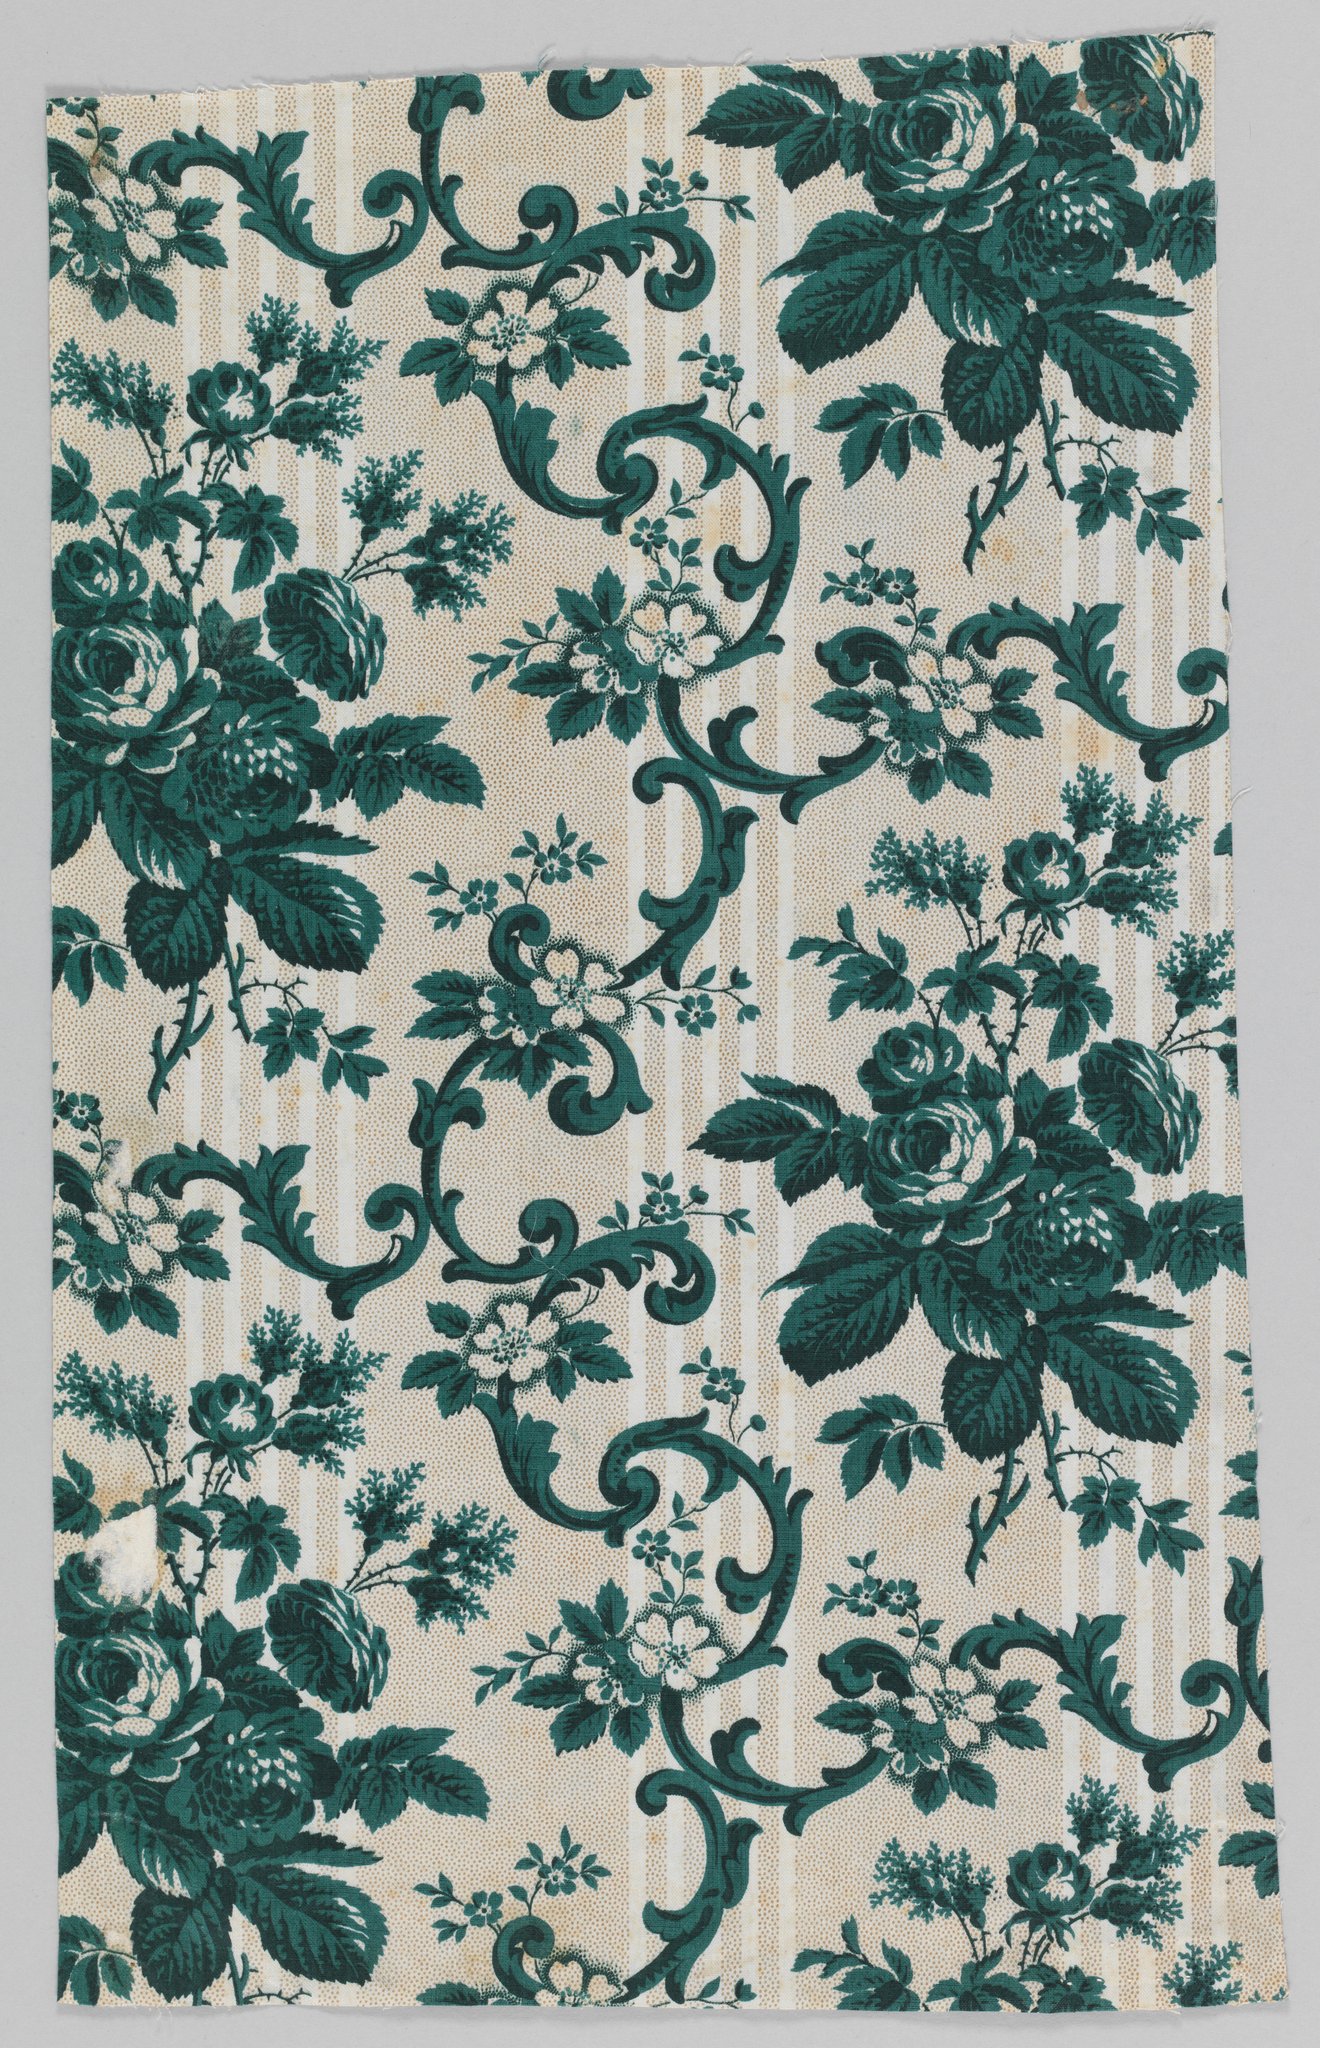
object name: piece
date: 1801-1900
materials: cotton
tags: roses